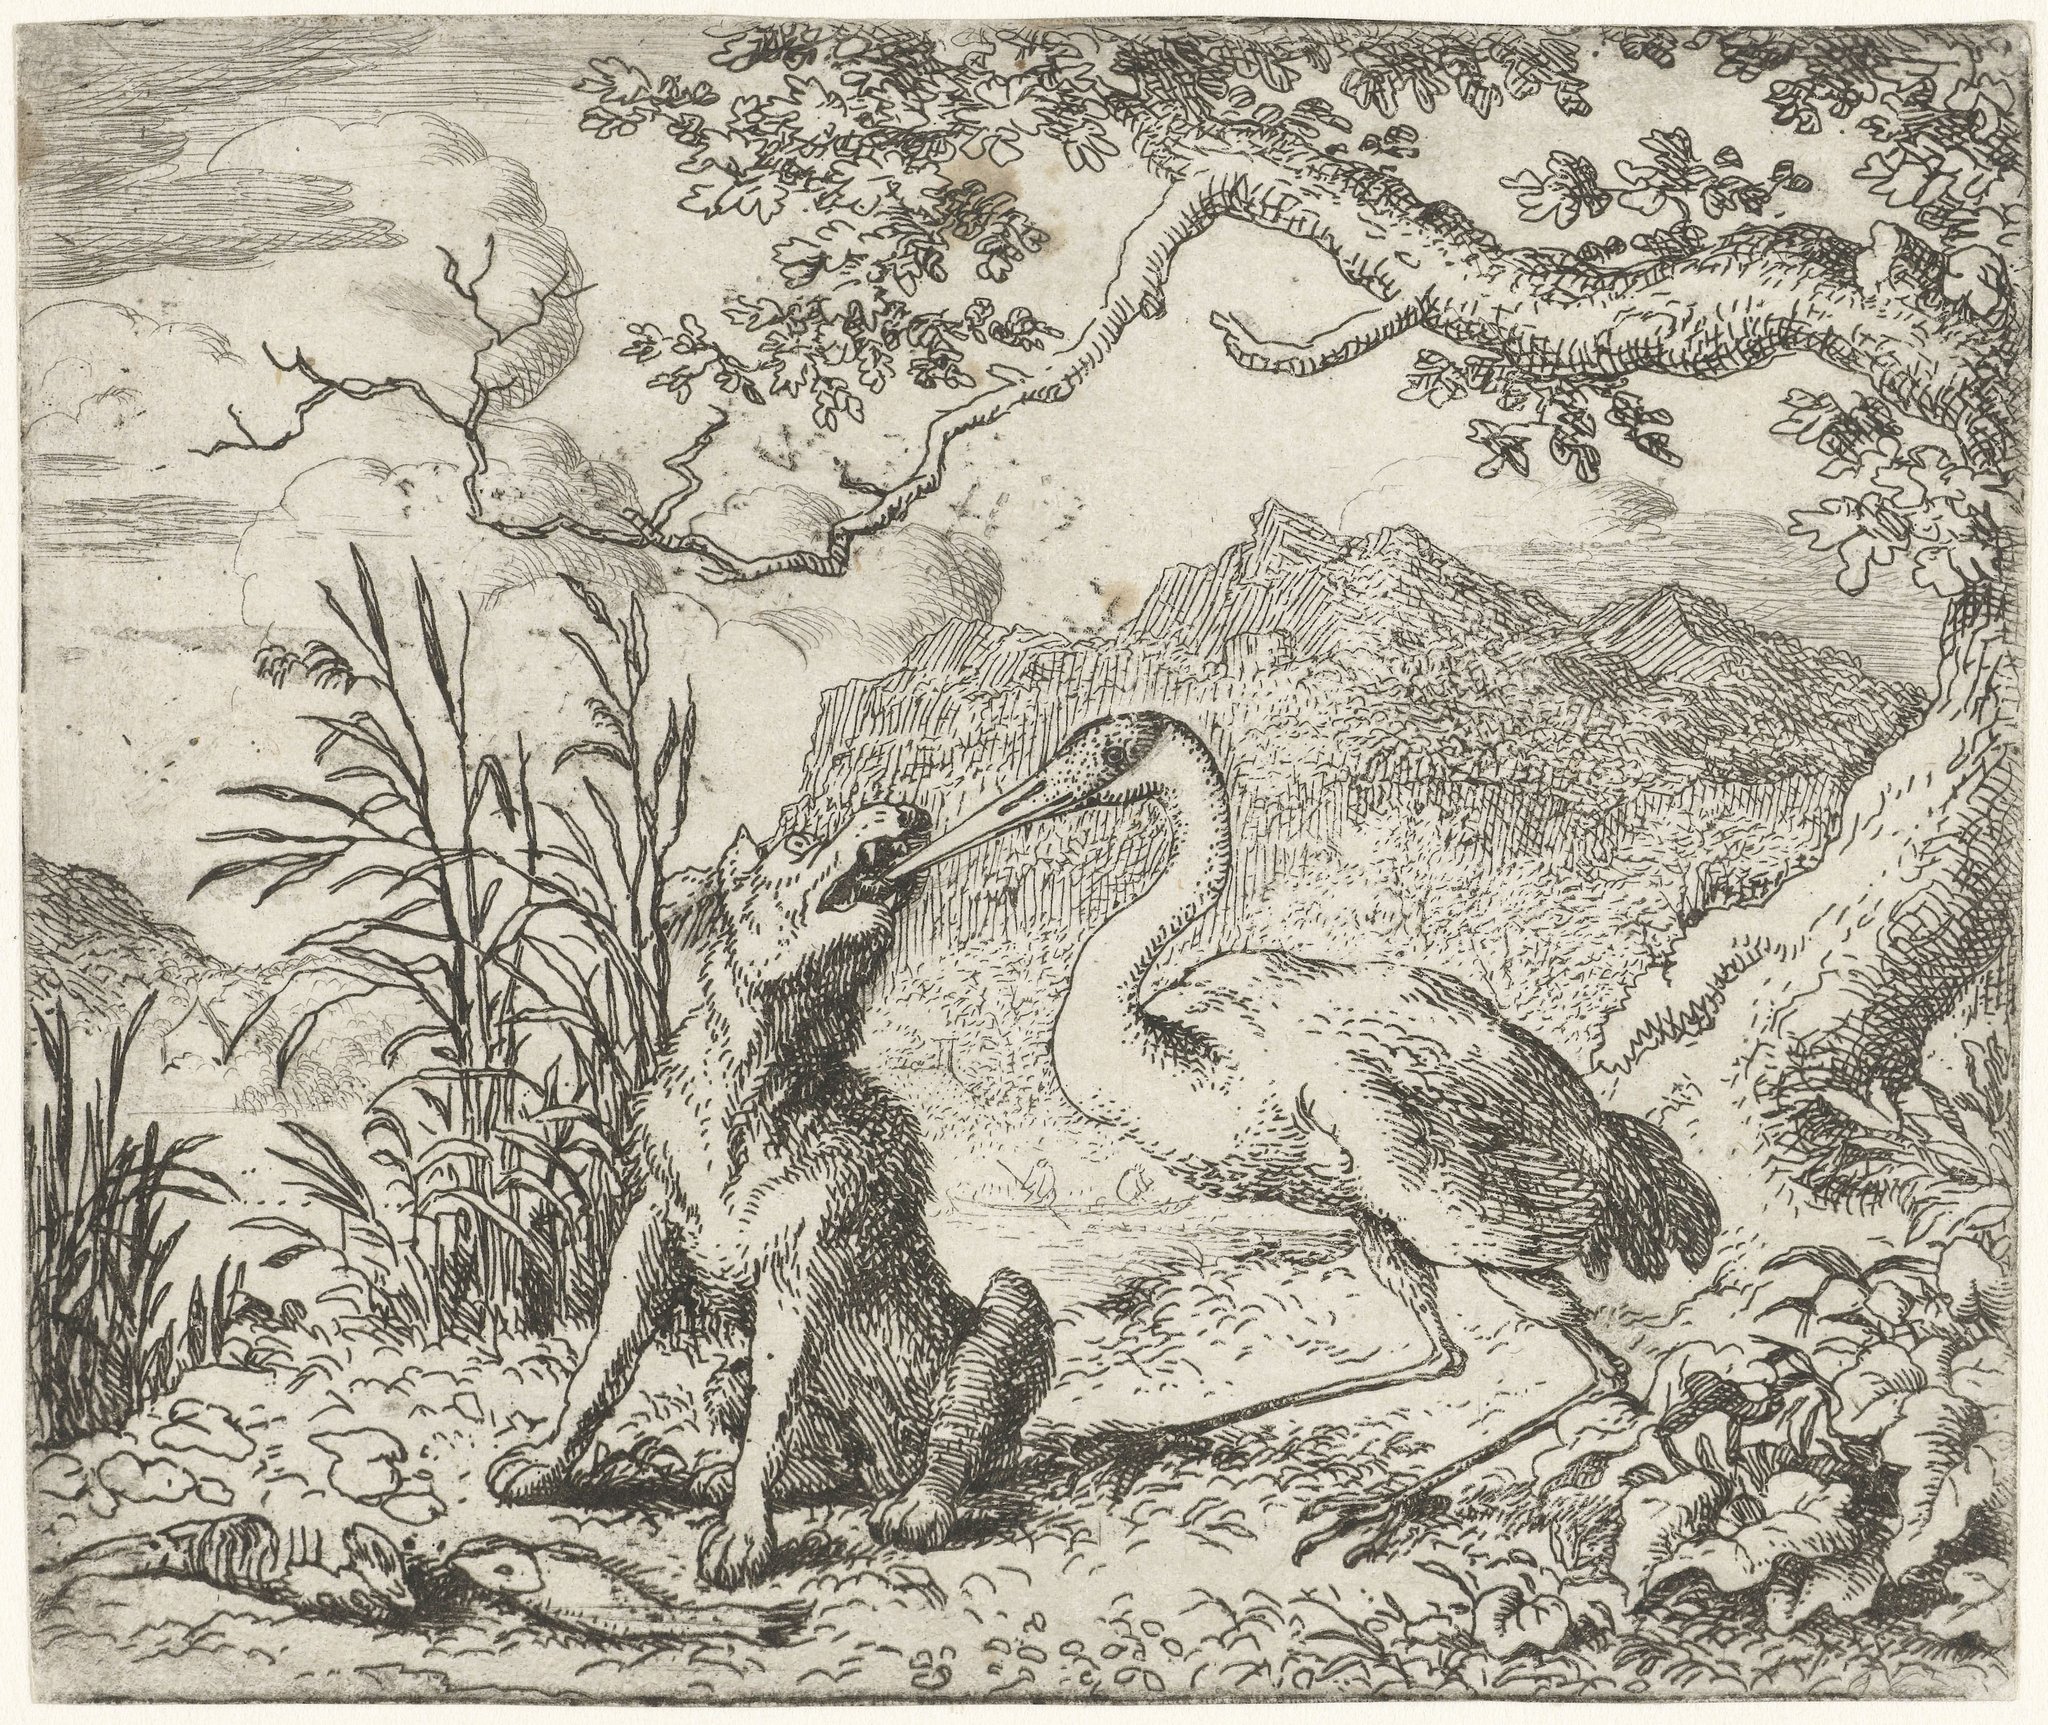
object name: print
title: Reinaert de vos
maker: allaert van everdingen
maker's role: draughtsman, painter, print maker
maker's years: 1621-1675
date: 1665-1675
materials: paper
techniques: etching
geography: netherlands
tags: beasts of prey, predatory animals: wolf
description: Een pelikaan steekt zijn bek in de muil van een wolf. Naast de wolf liggen vissengraten.